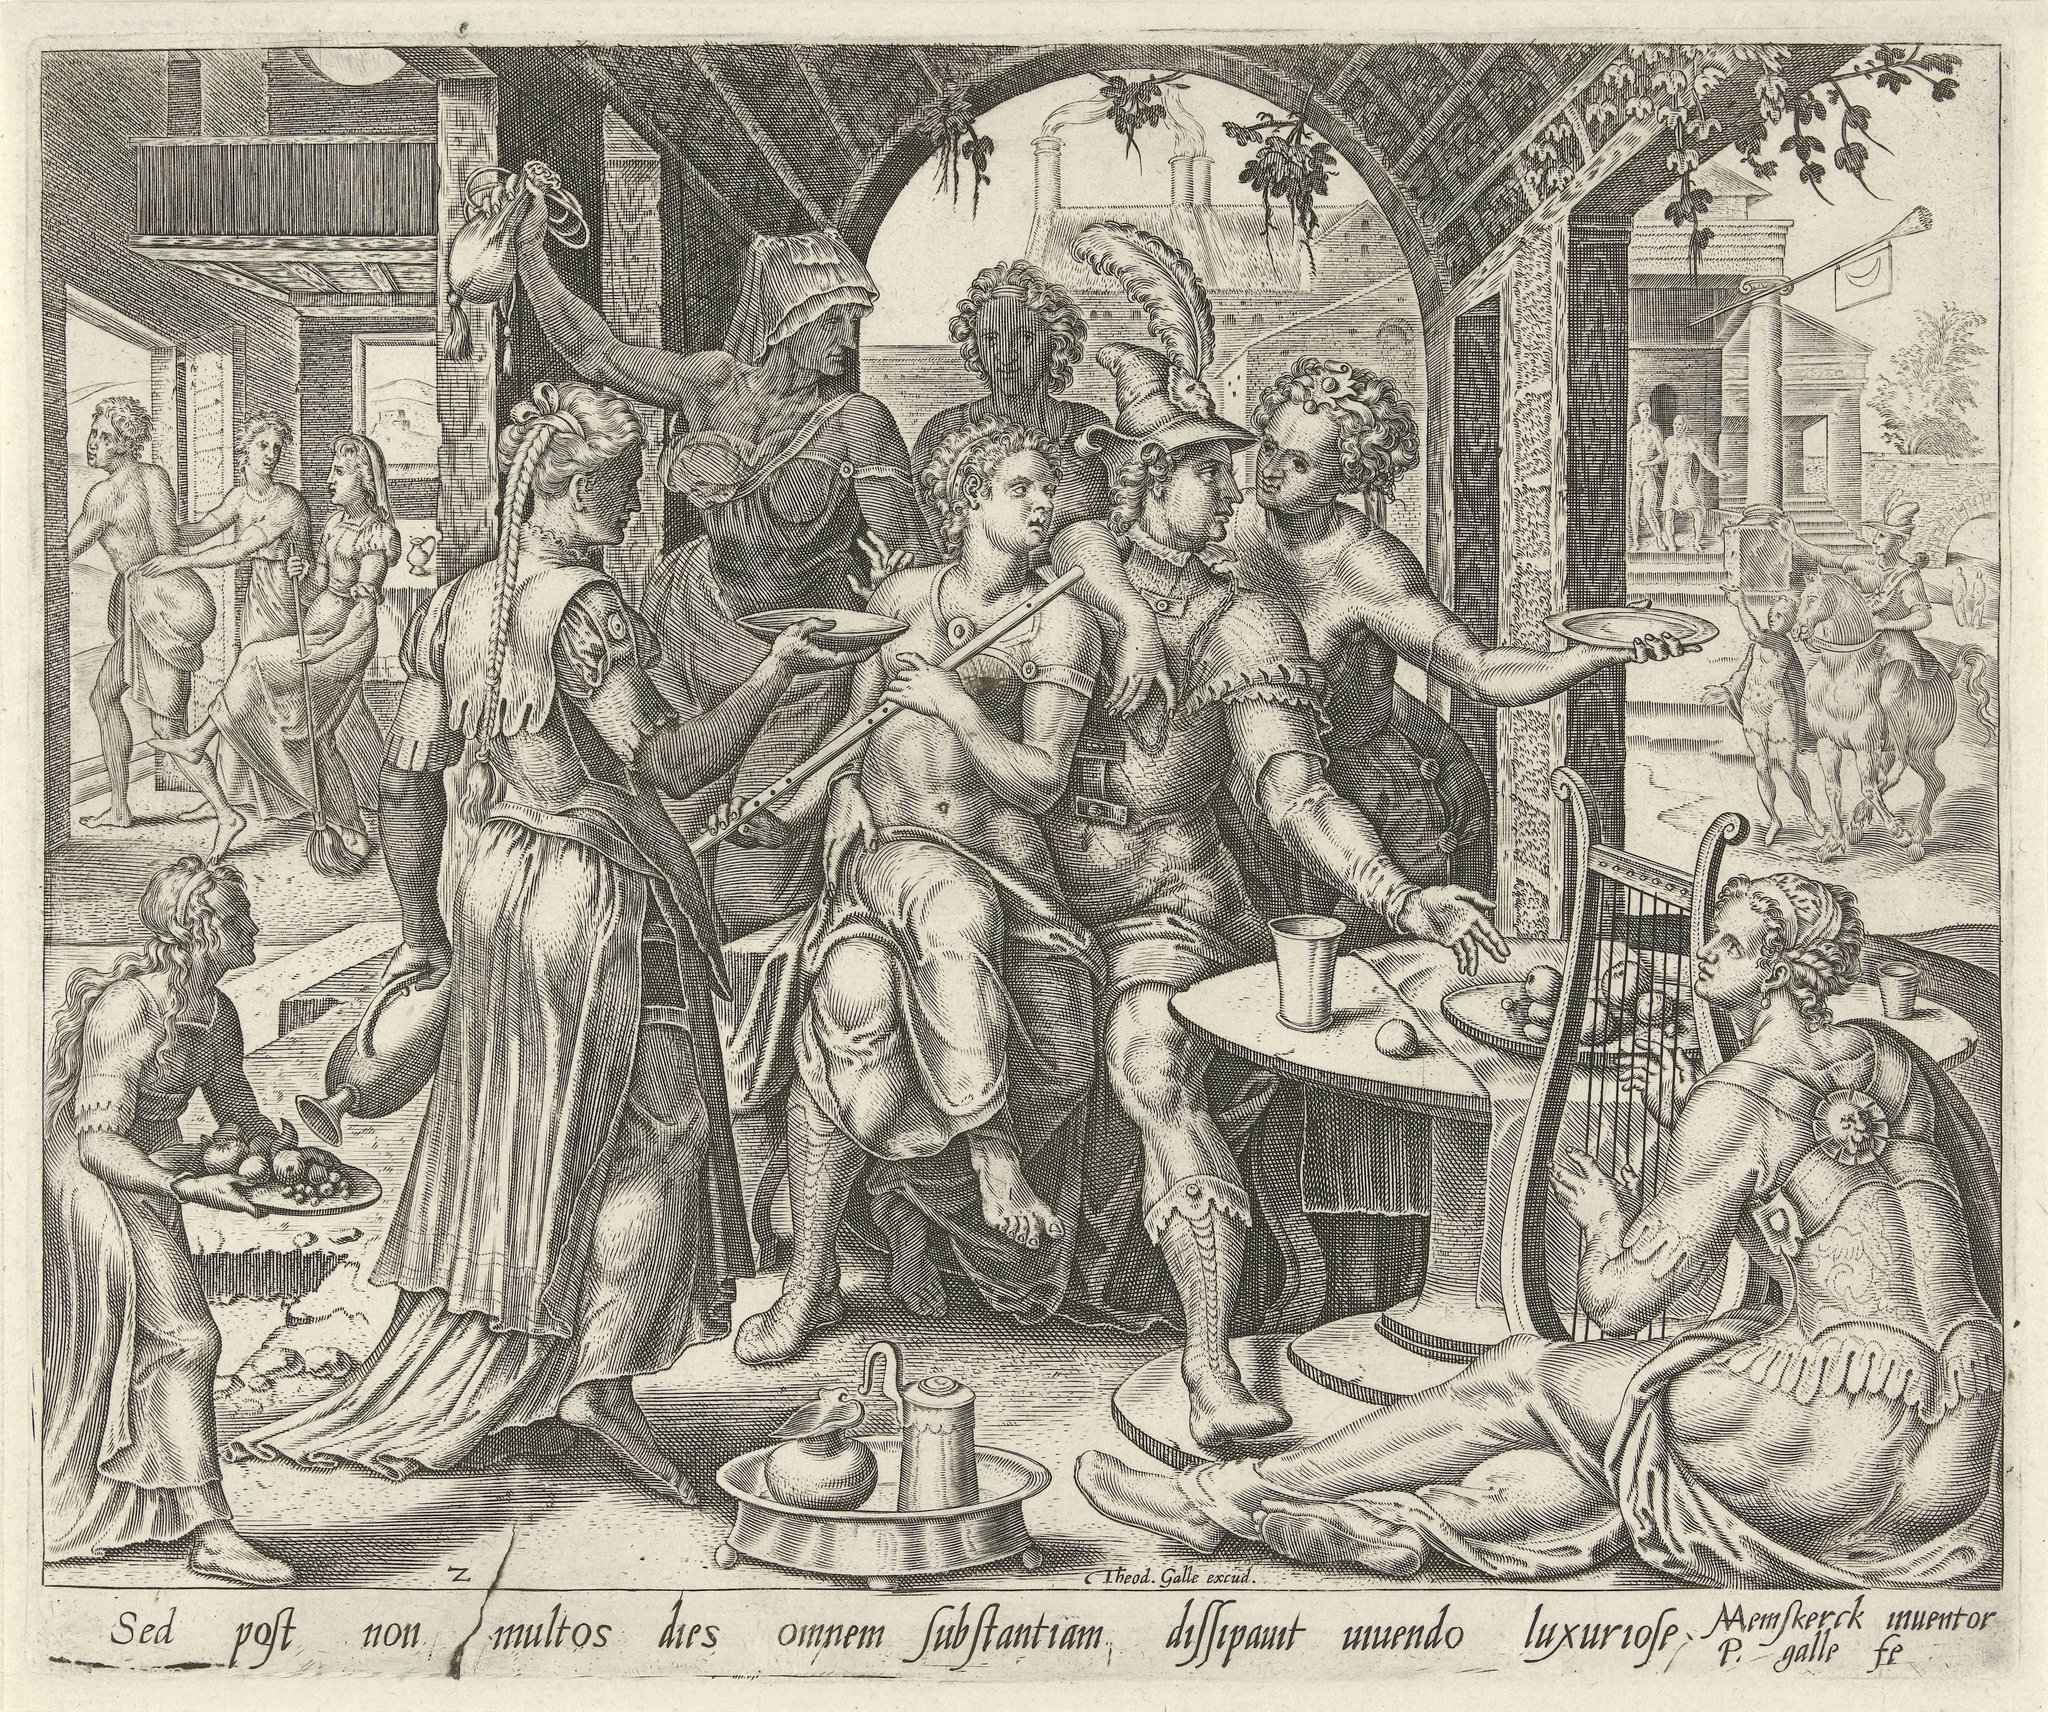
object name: print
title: Gelijkenis van de verloren zoon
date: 1596-1633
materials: paper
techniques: engraving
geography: antwerp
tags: when all his money is squandered the prodigal son is chased away by the harlots, the parable of the prodigal son (luke 15:11-32), the prodigal son in the midst of prostitutes feasting and dissipating his patrimony, usually in a brothel or inn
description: De verloren zoon verkwist zijn erfenis in een bordeel. Zeven vrouwen omzorgen hem, maken muziek voor hem en brengen hem eten en drinken. Rechts is door het raam te zien hoe de verloren zoon arriveert, links is te zien hoe hem, nadat het geld op is, de deur gewezen wordt.